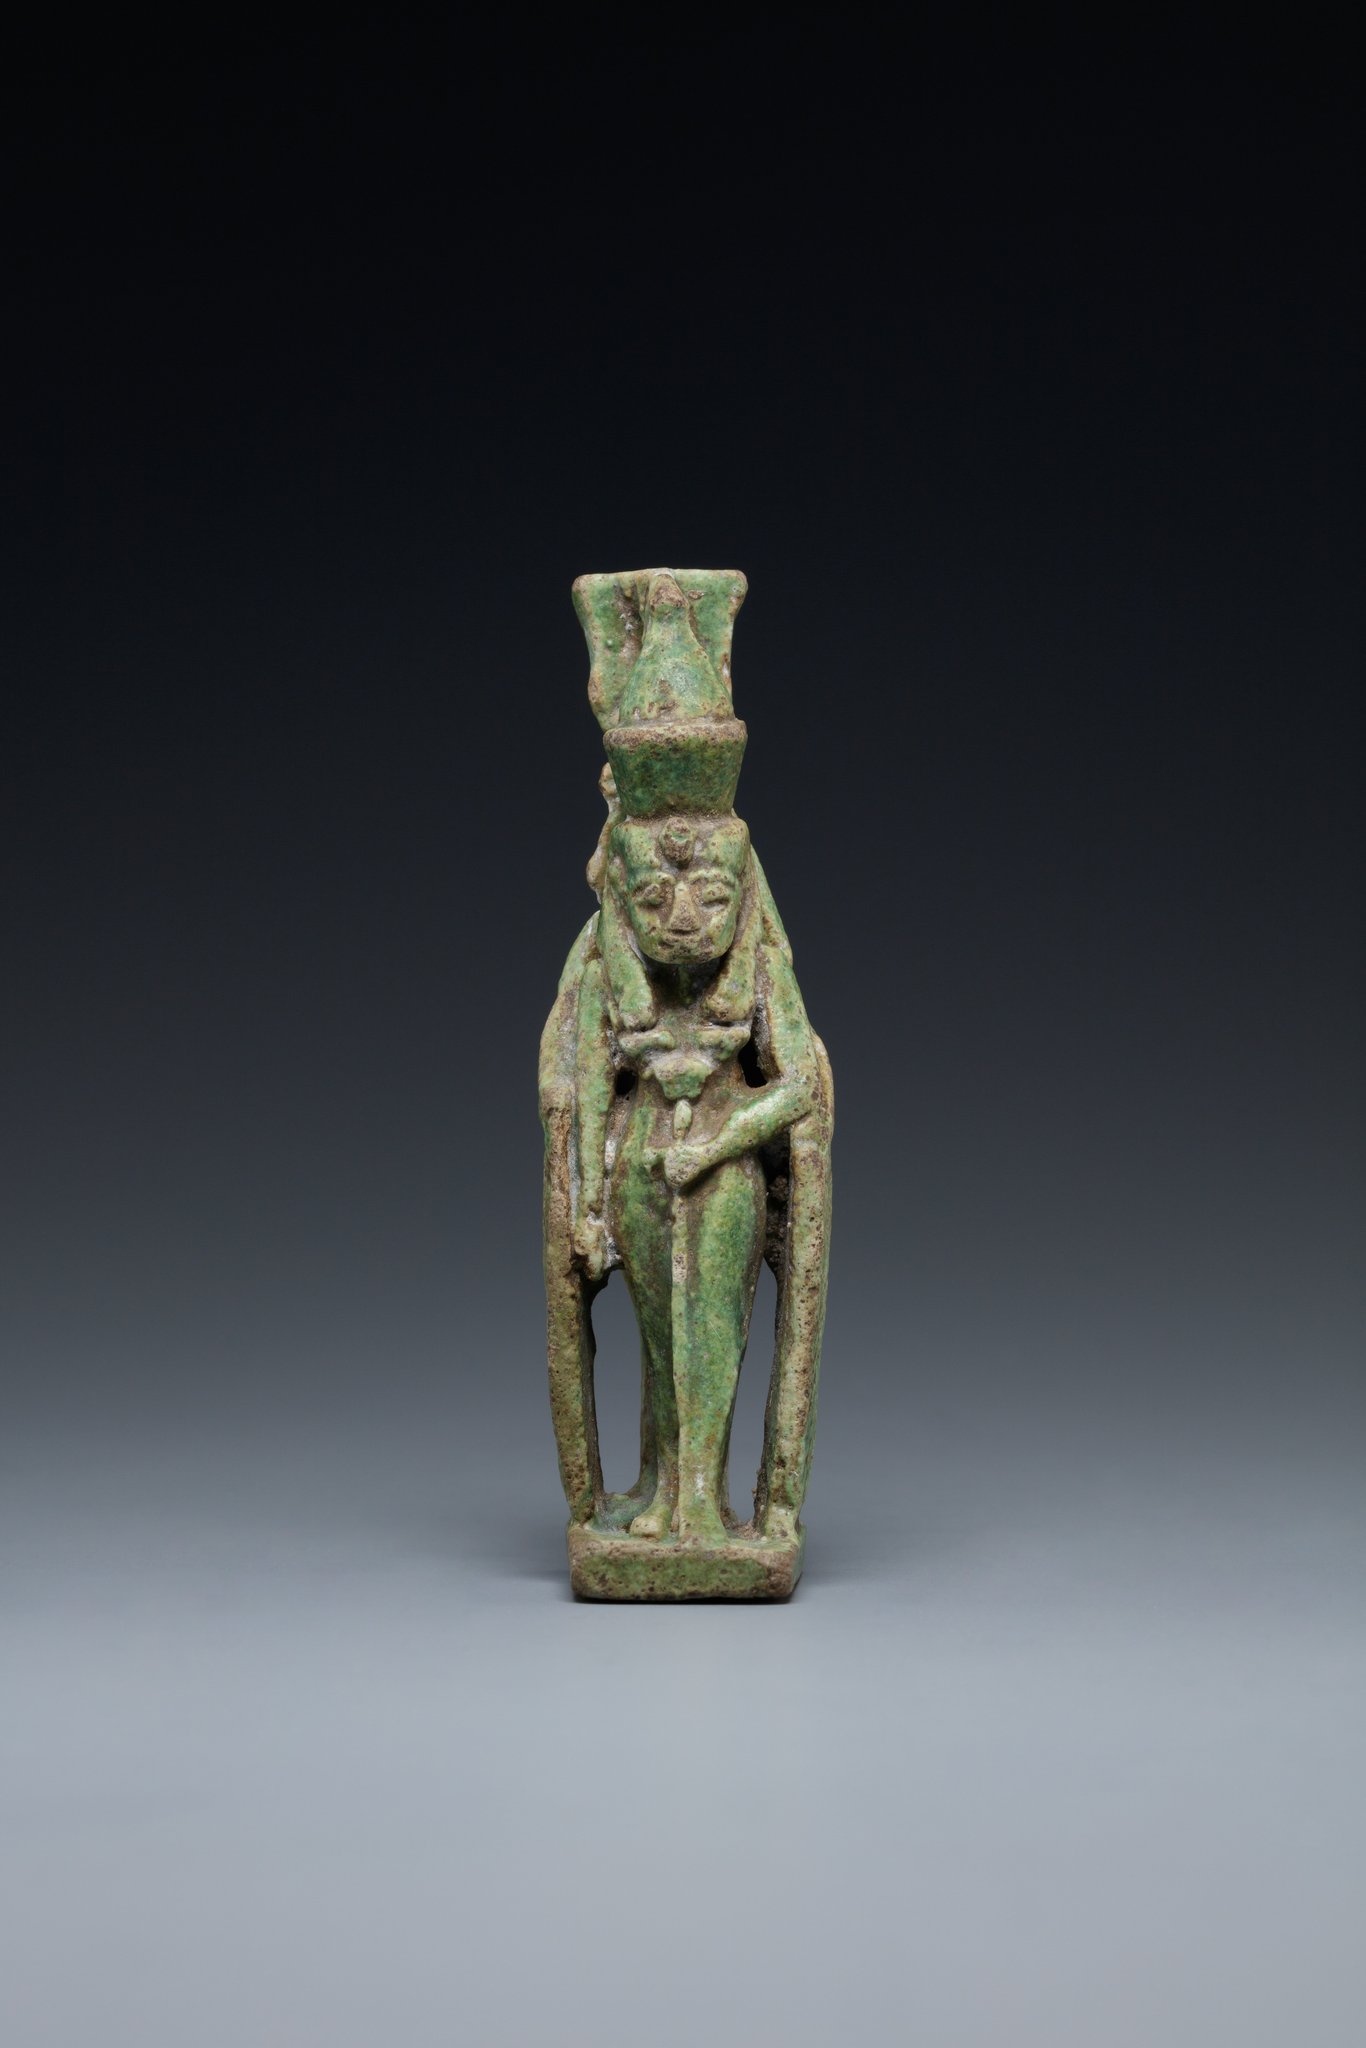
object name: necklace, bead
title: Composite Figure of Mut and Isis Amulet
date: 664-630 BCE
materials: faience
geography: egypt